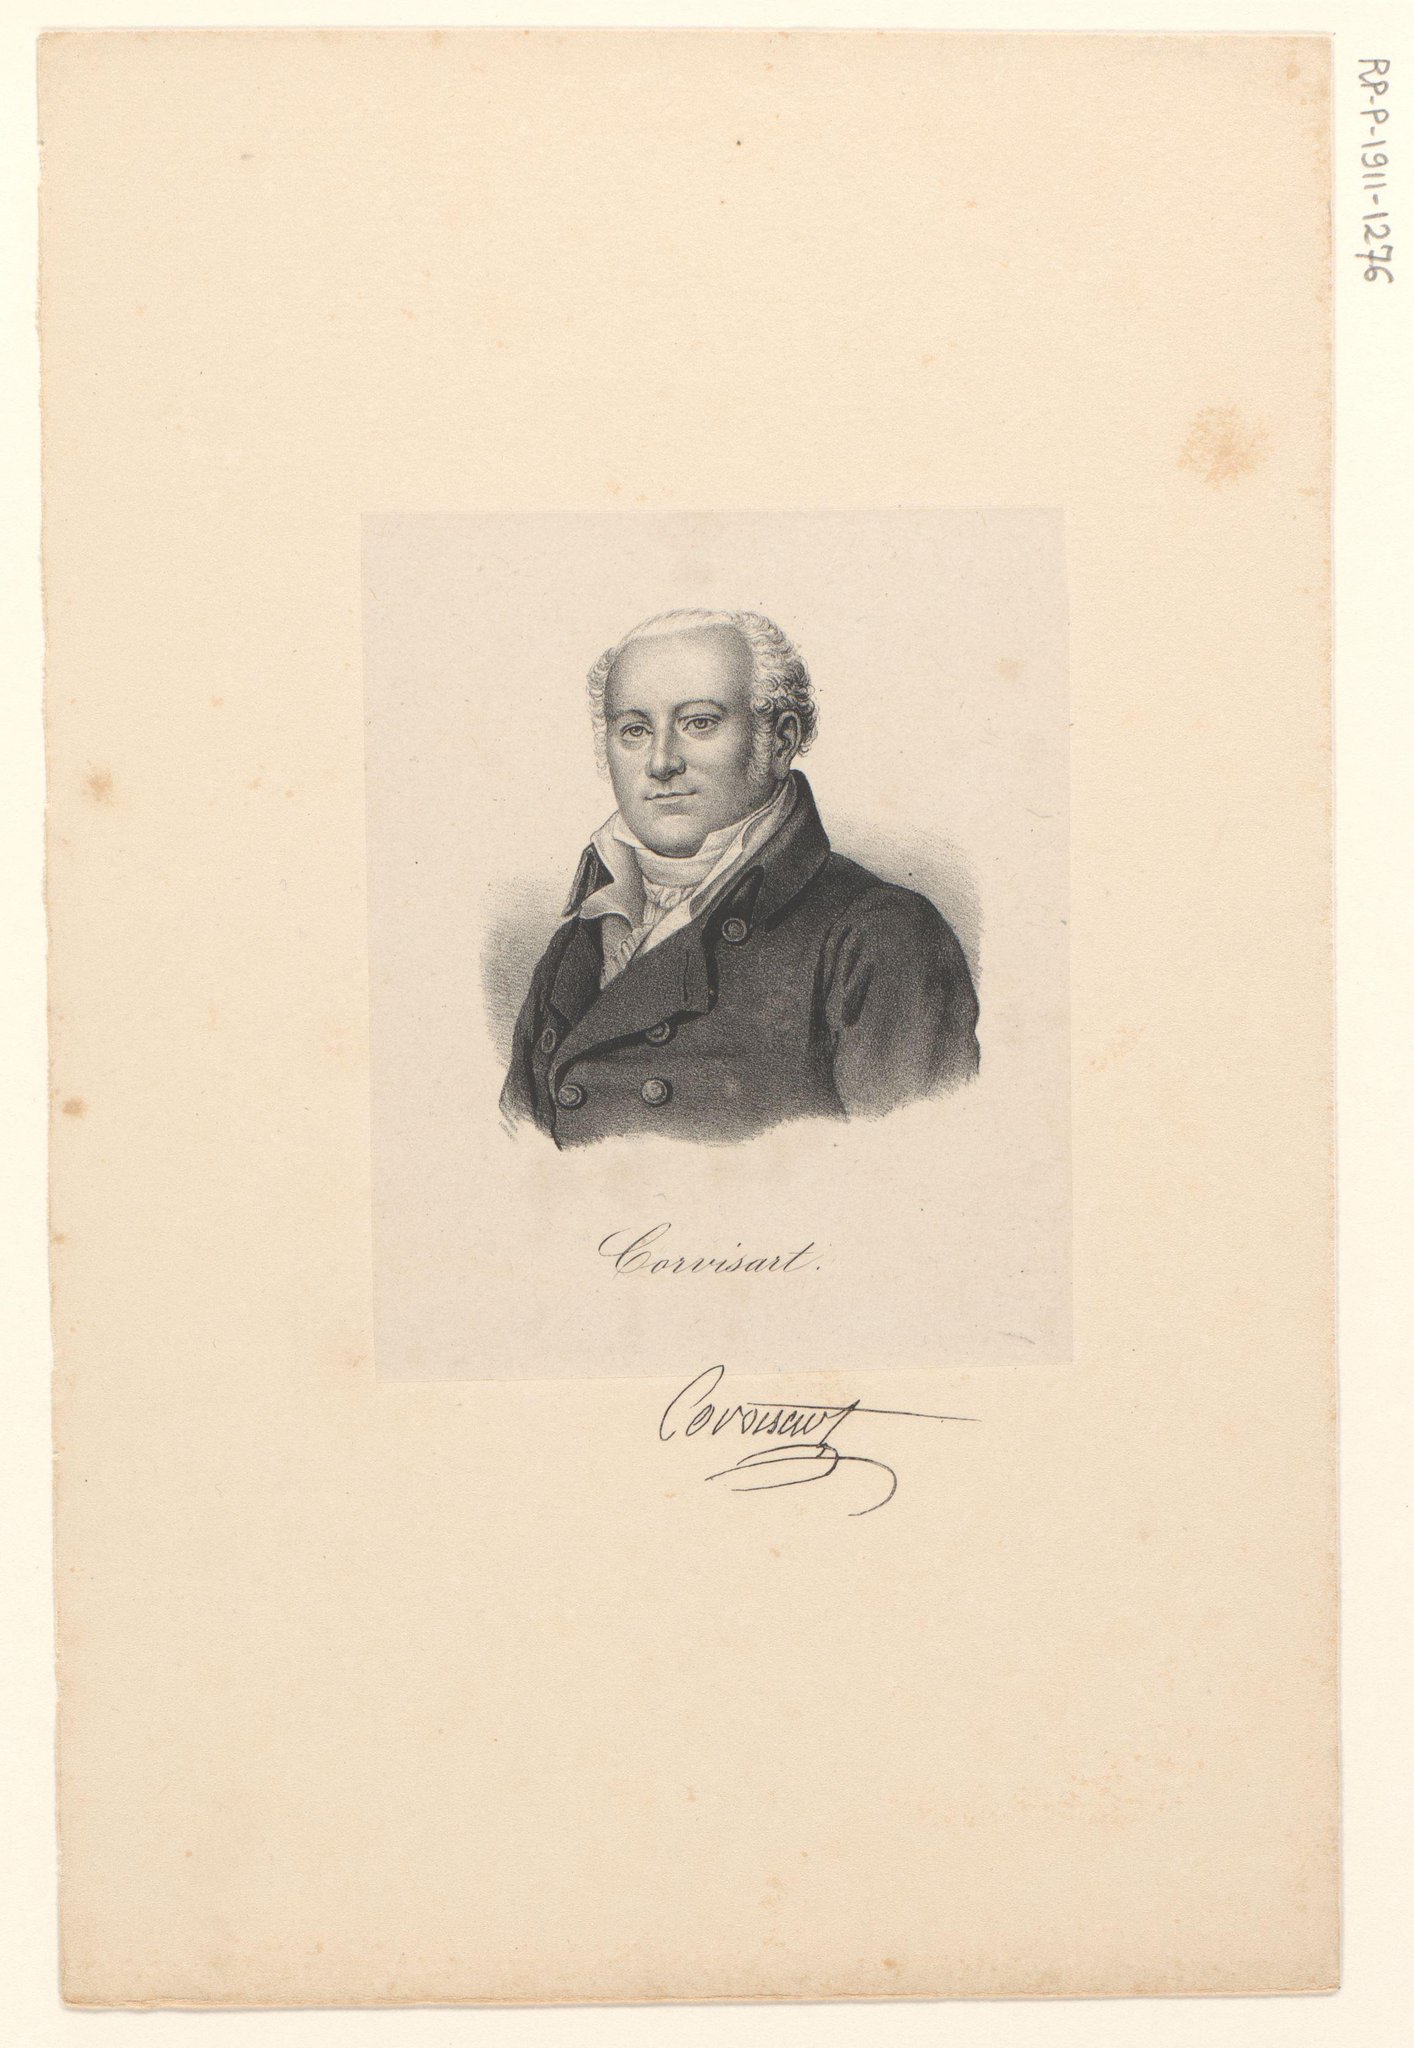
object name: print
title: Corvisart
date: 1818-1842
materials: paper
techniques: lithograph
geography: paris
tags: historical persons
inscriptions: collector's mark: Lugt 2228a